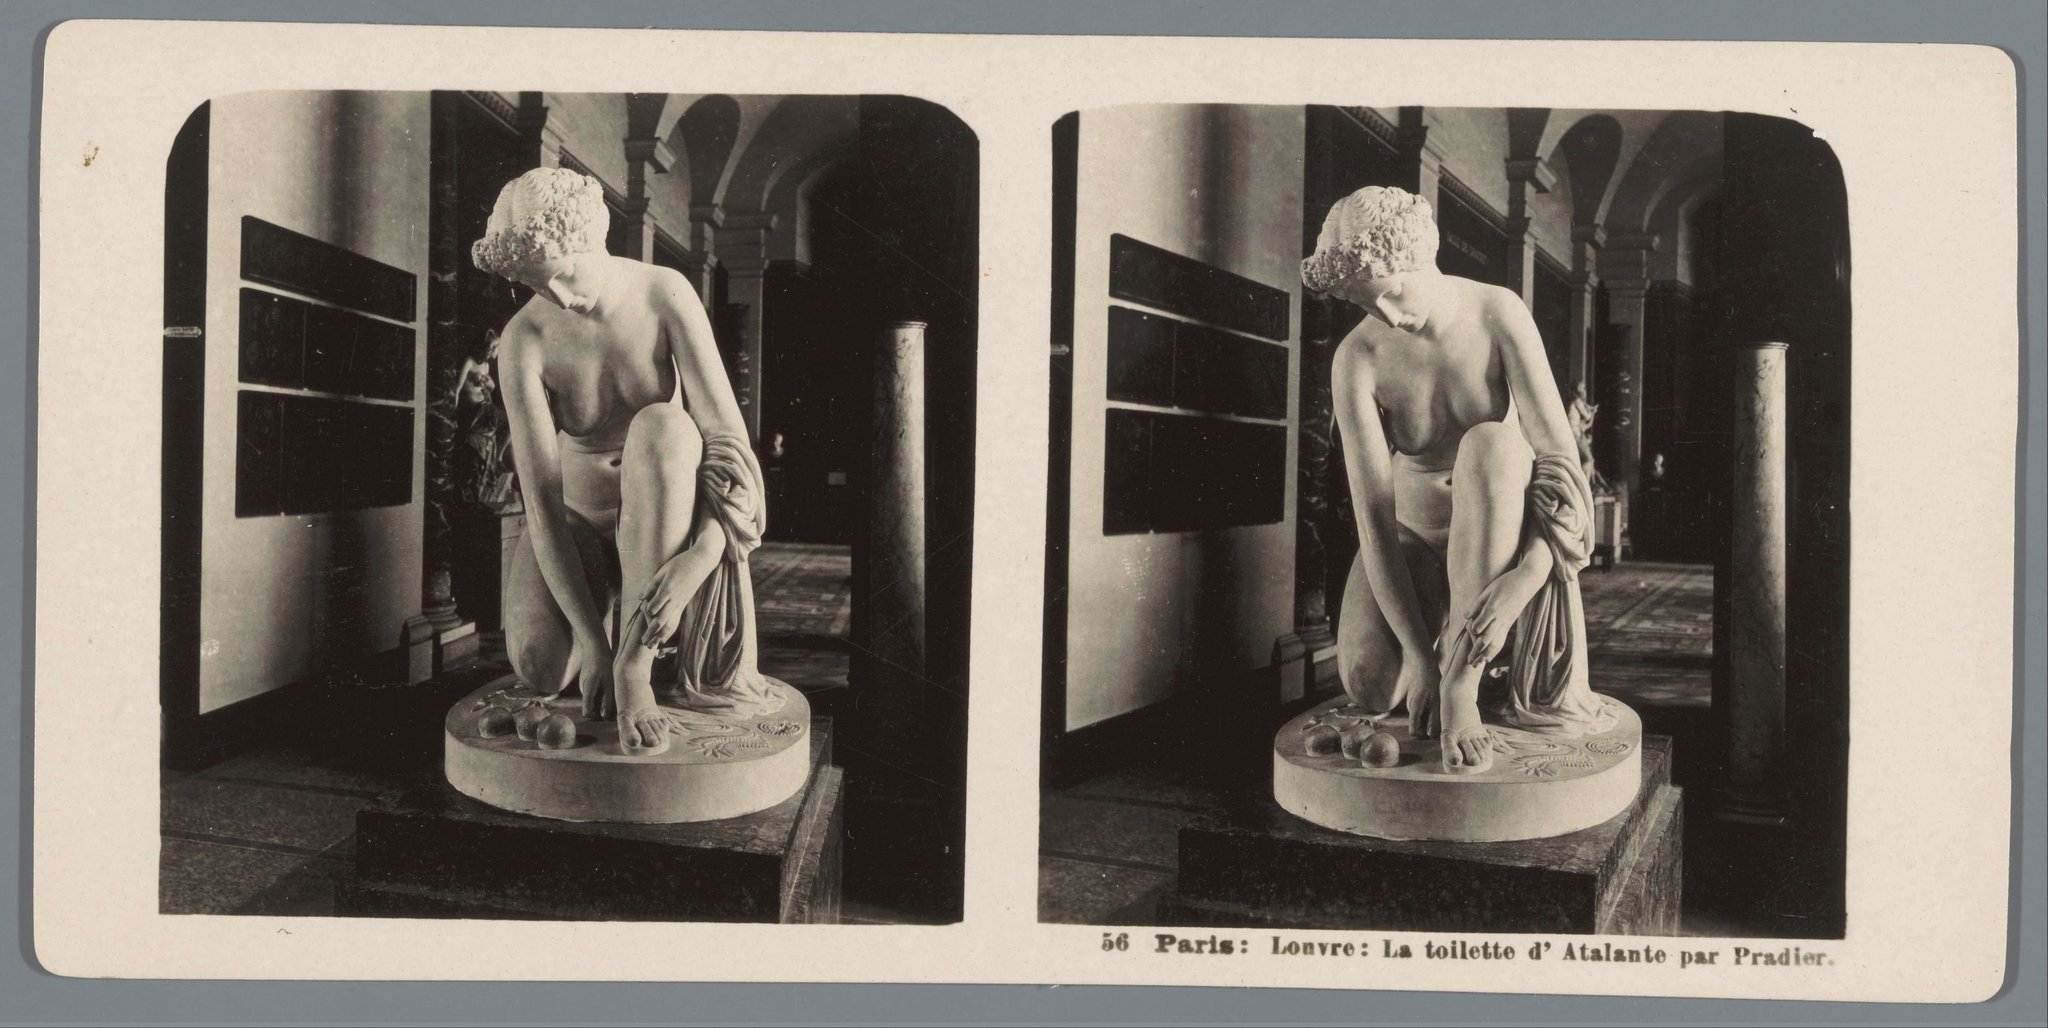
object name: stereograph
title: Paris: Louvre: La toilette d'Atalante par Pradier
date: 1904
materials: cardboard, photographic support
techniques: gelatin silver print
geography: louvre museum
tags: (story of) atalante, permanent exhibition, museum, sculpture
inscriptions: inscription: ‘Neue Photographische Gesellschaft A.-G. Steglitz-Berlin 1904.’, number: ‘56’